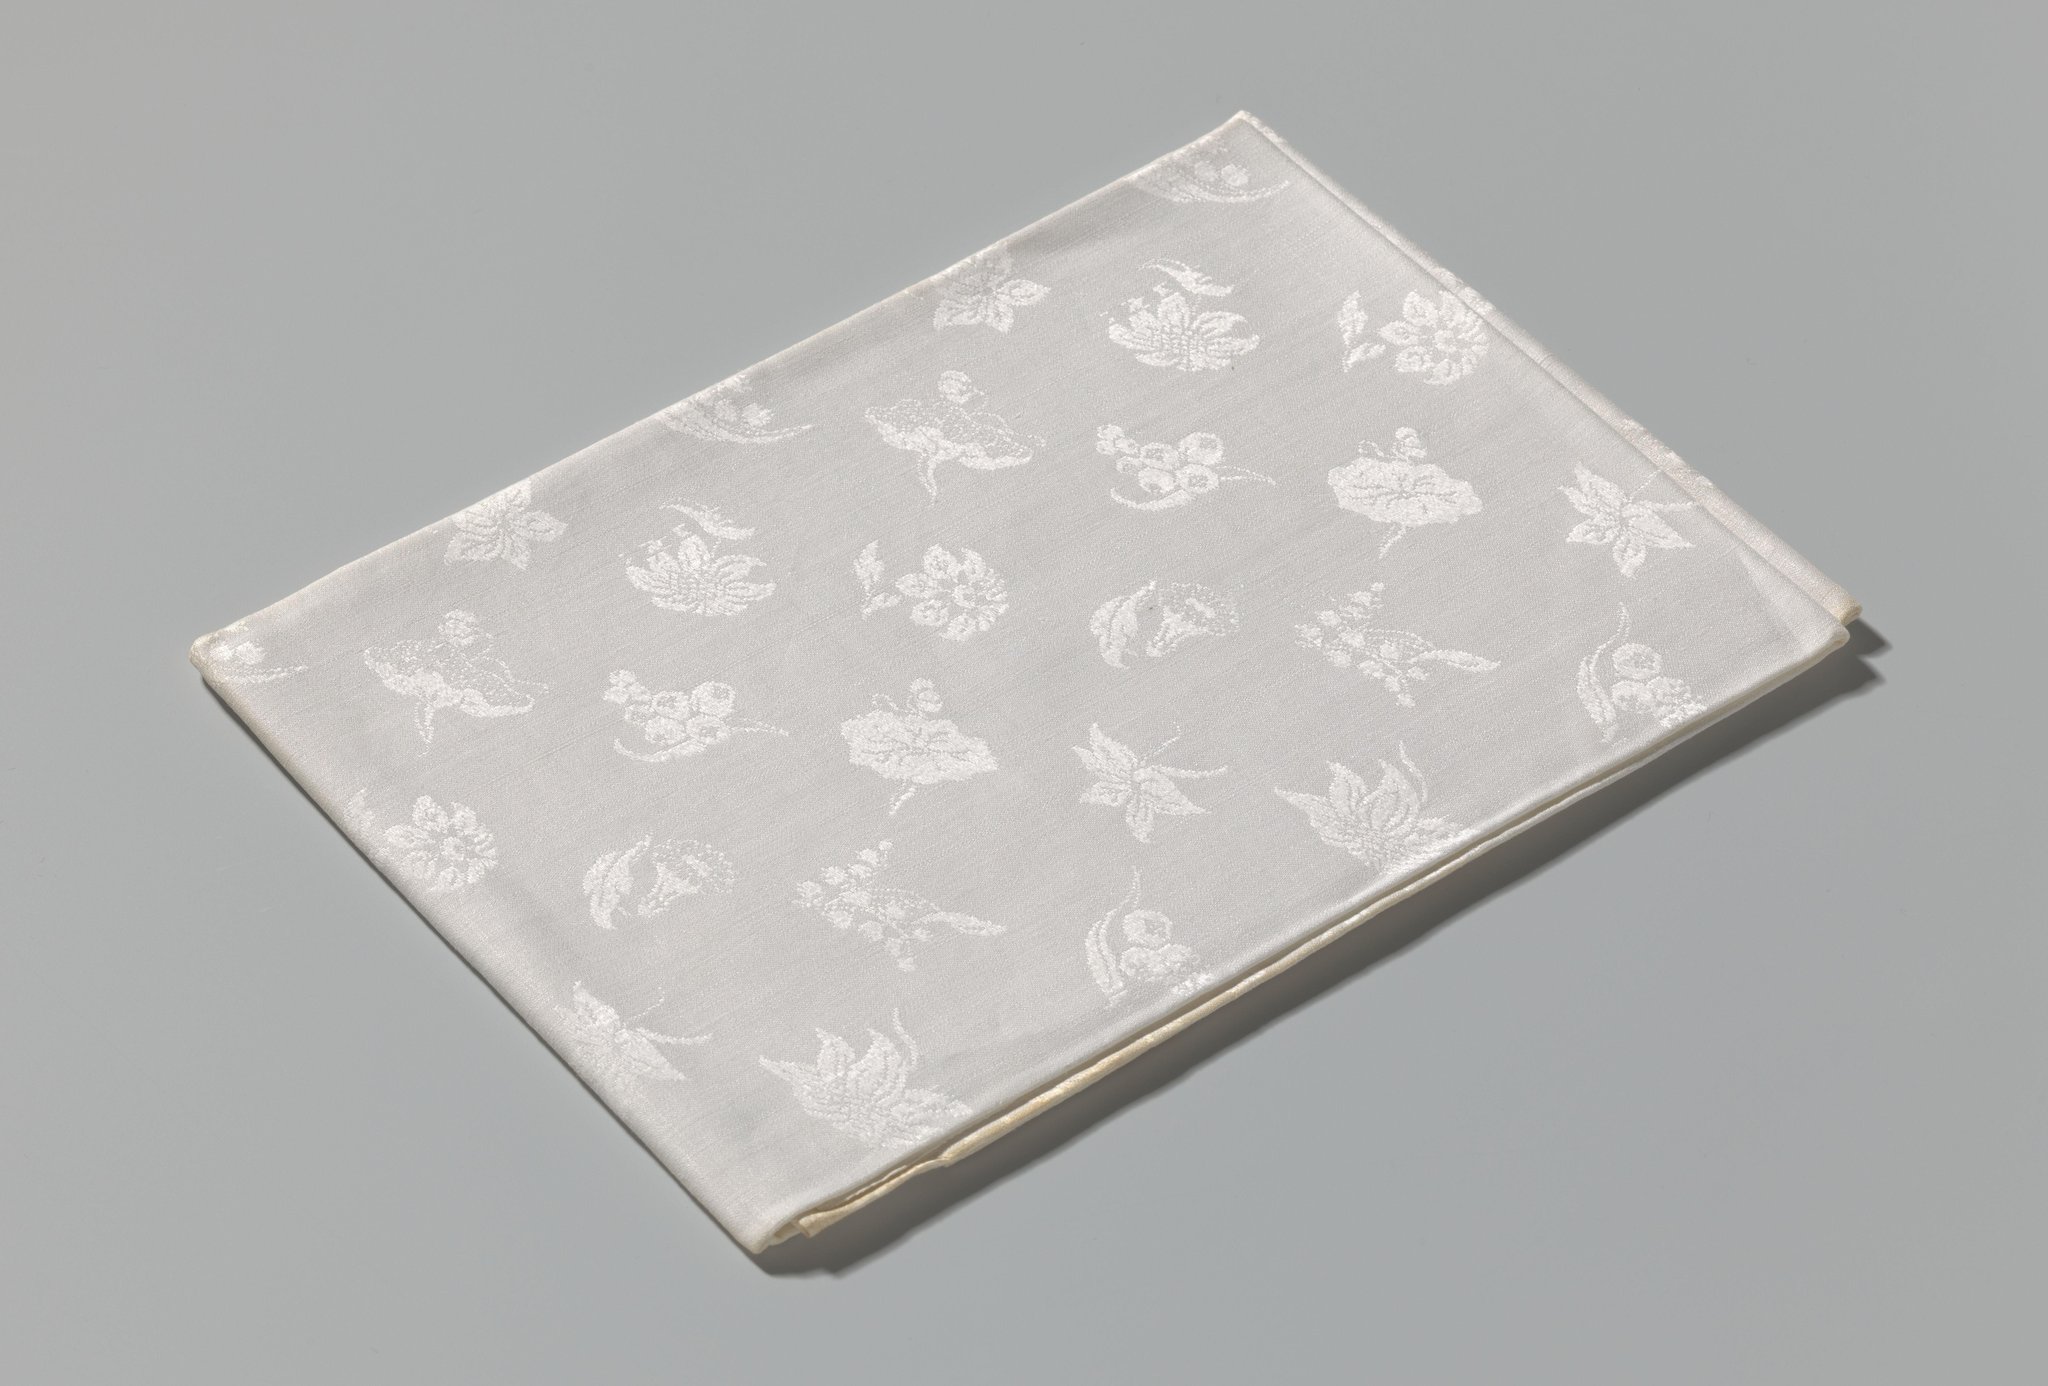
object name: napkin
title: Servet van wit linnendamast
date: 1800-1900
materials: linen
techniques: damask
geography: netherlands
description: Wit linnen damasten servet met gestrooide bloempjes en bloemenrand.